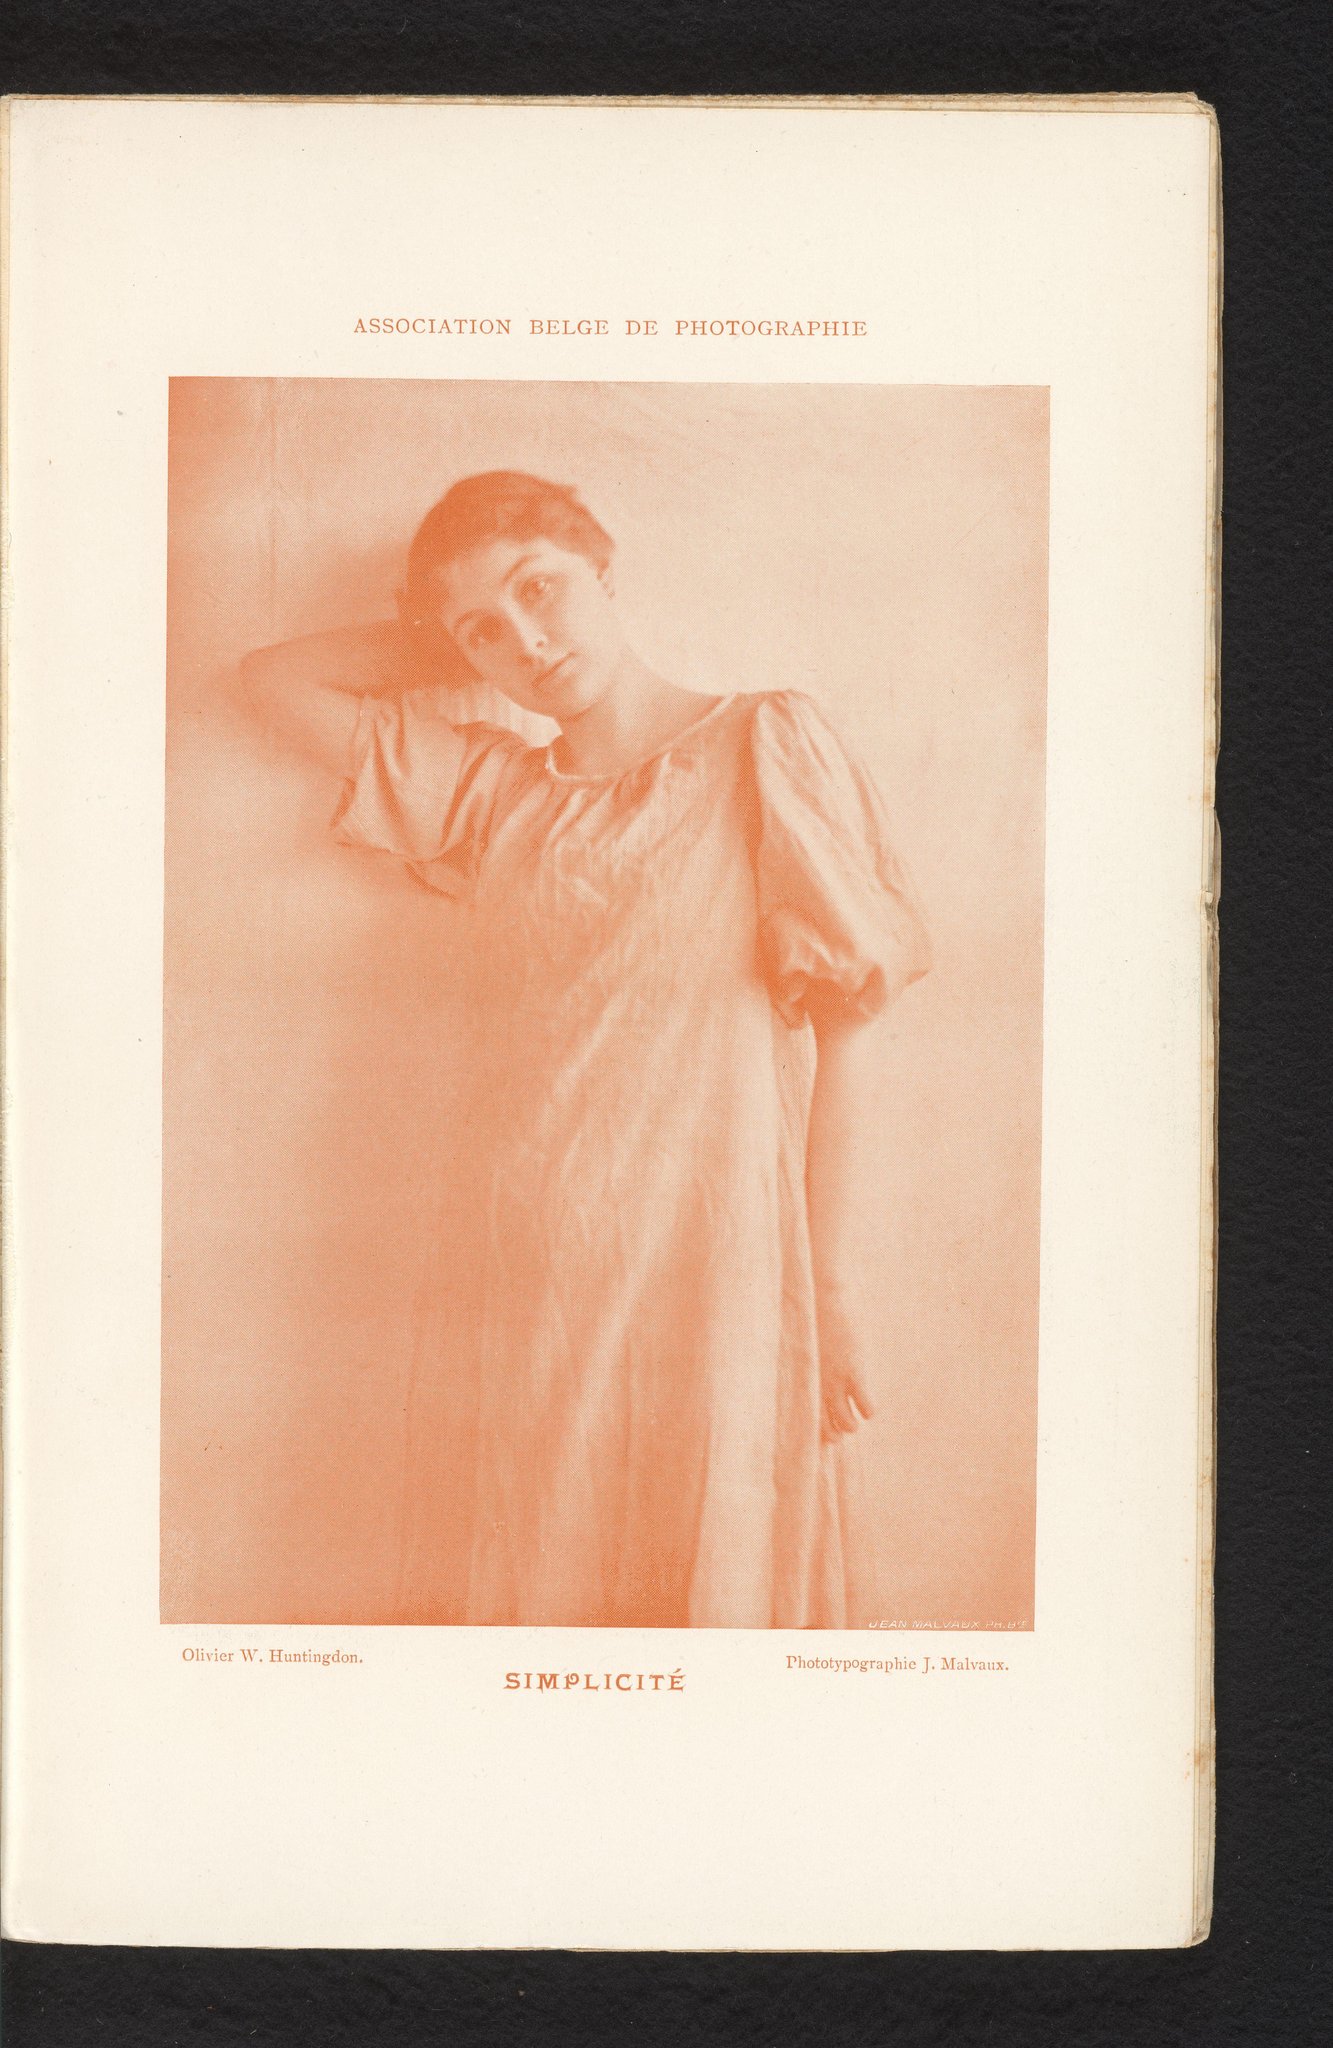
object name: page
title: Simplicité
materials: paper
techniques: autotype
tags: historical persons not known by name - bb - woman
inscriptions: inscription: ‘ASSOCIATION BELGE DE PHOTOGRAPHIE’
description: Prent op derde ongenummerde pagina na pagina XVI.